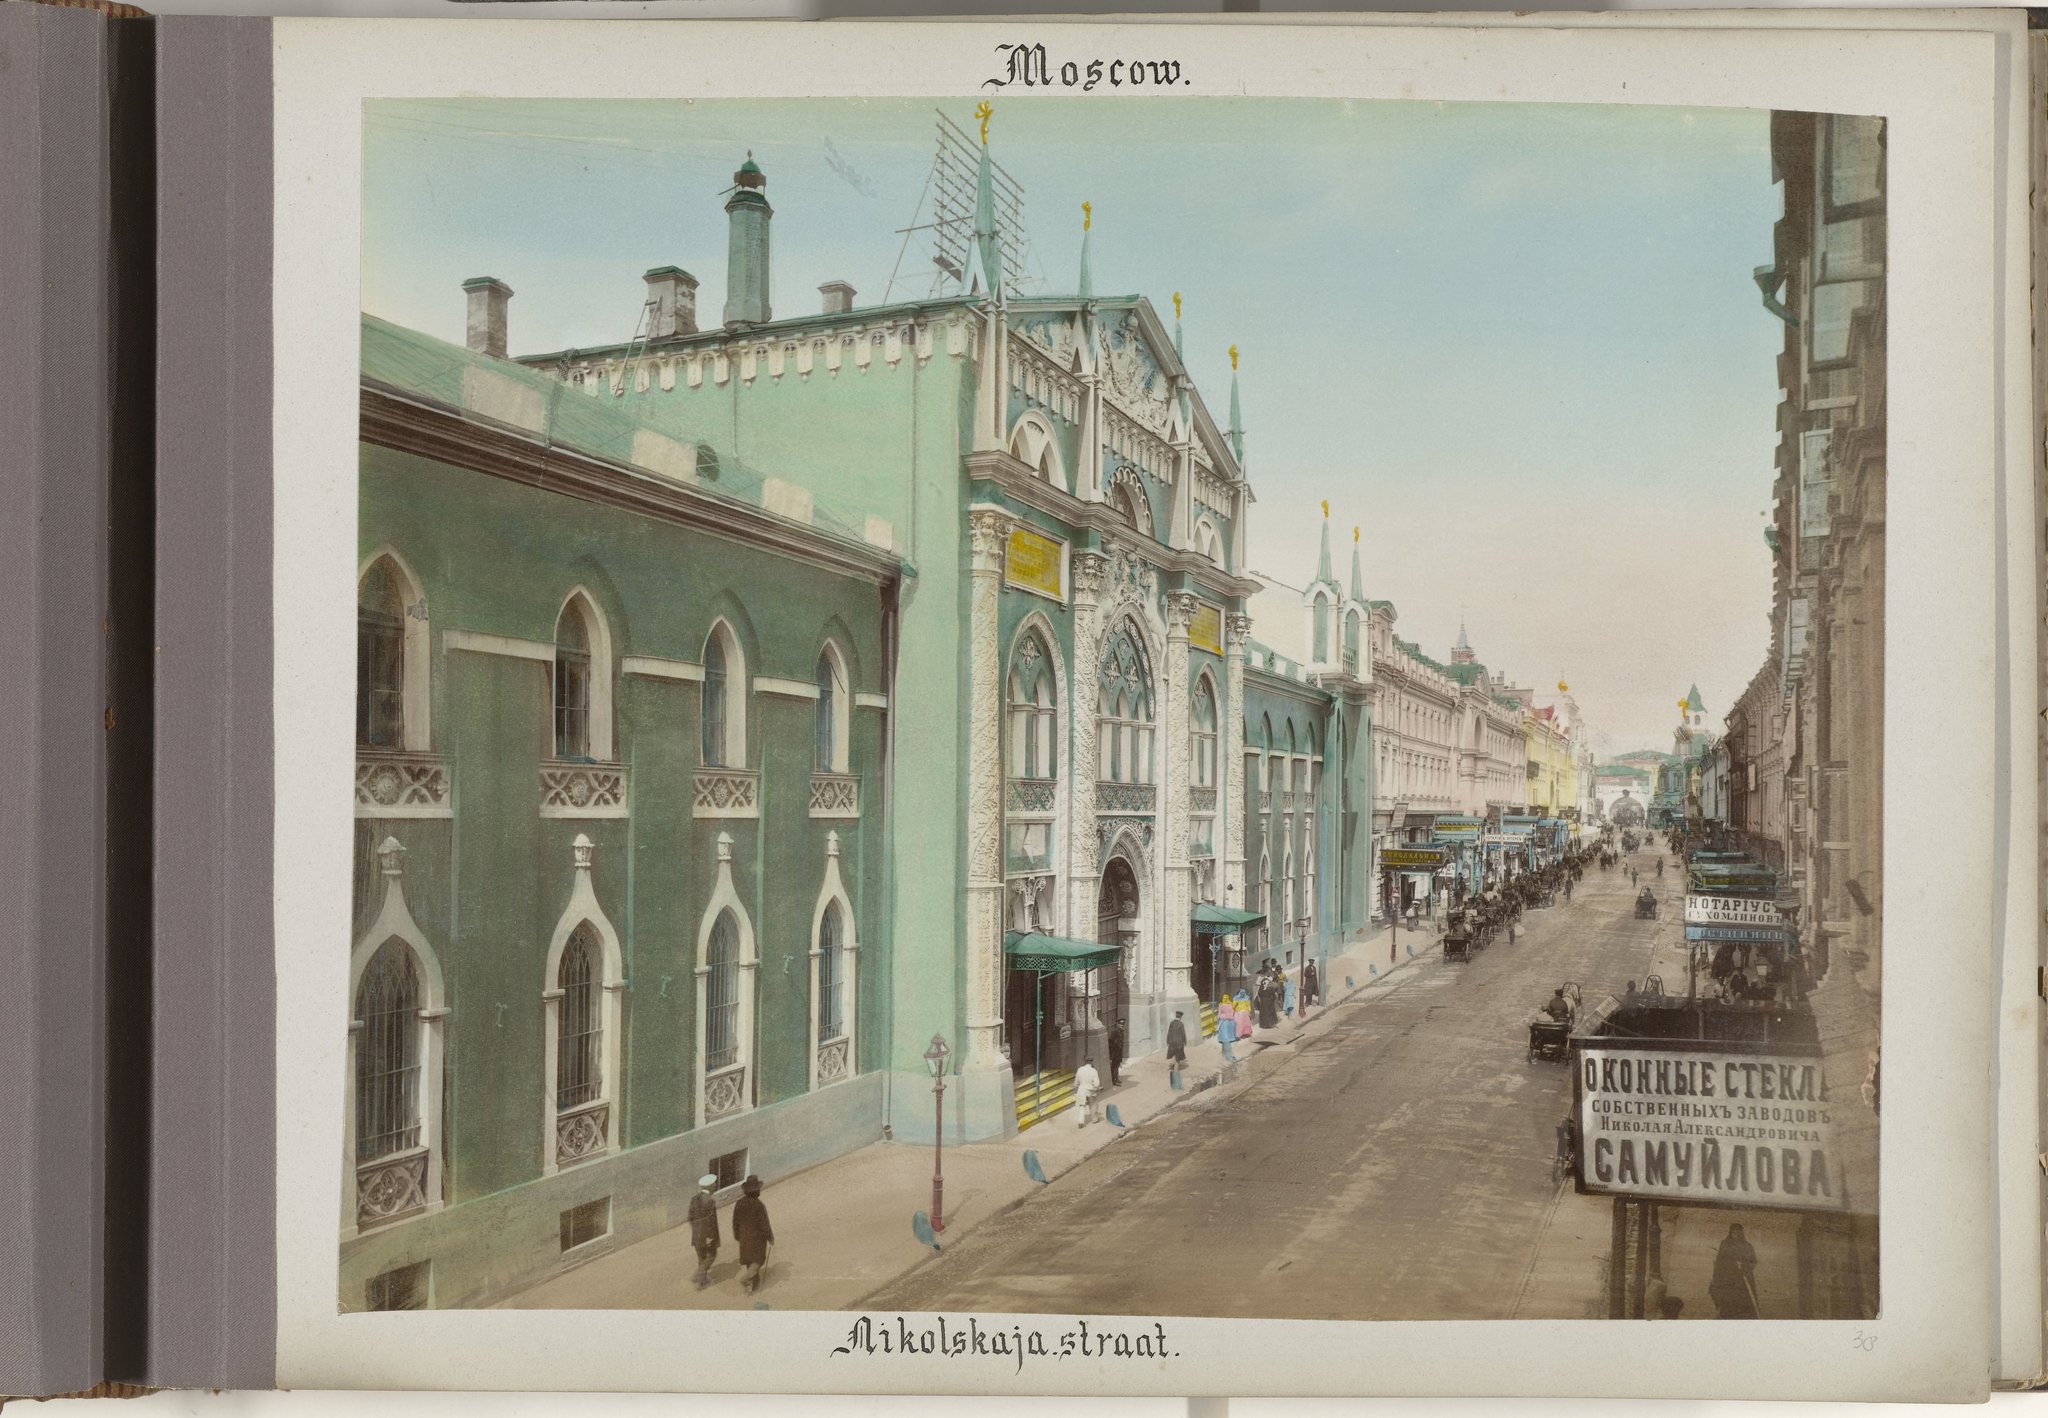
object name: photograph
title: Nikolskaya straat met winkels en theaters in Moskou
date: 1898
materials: paper, photographic support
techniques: albumen print